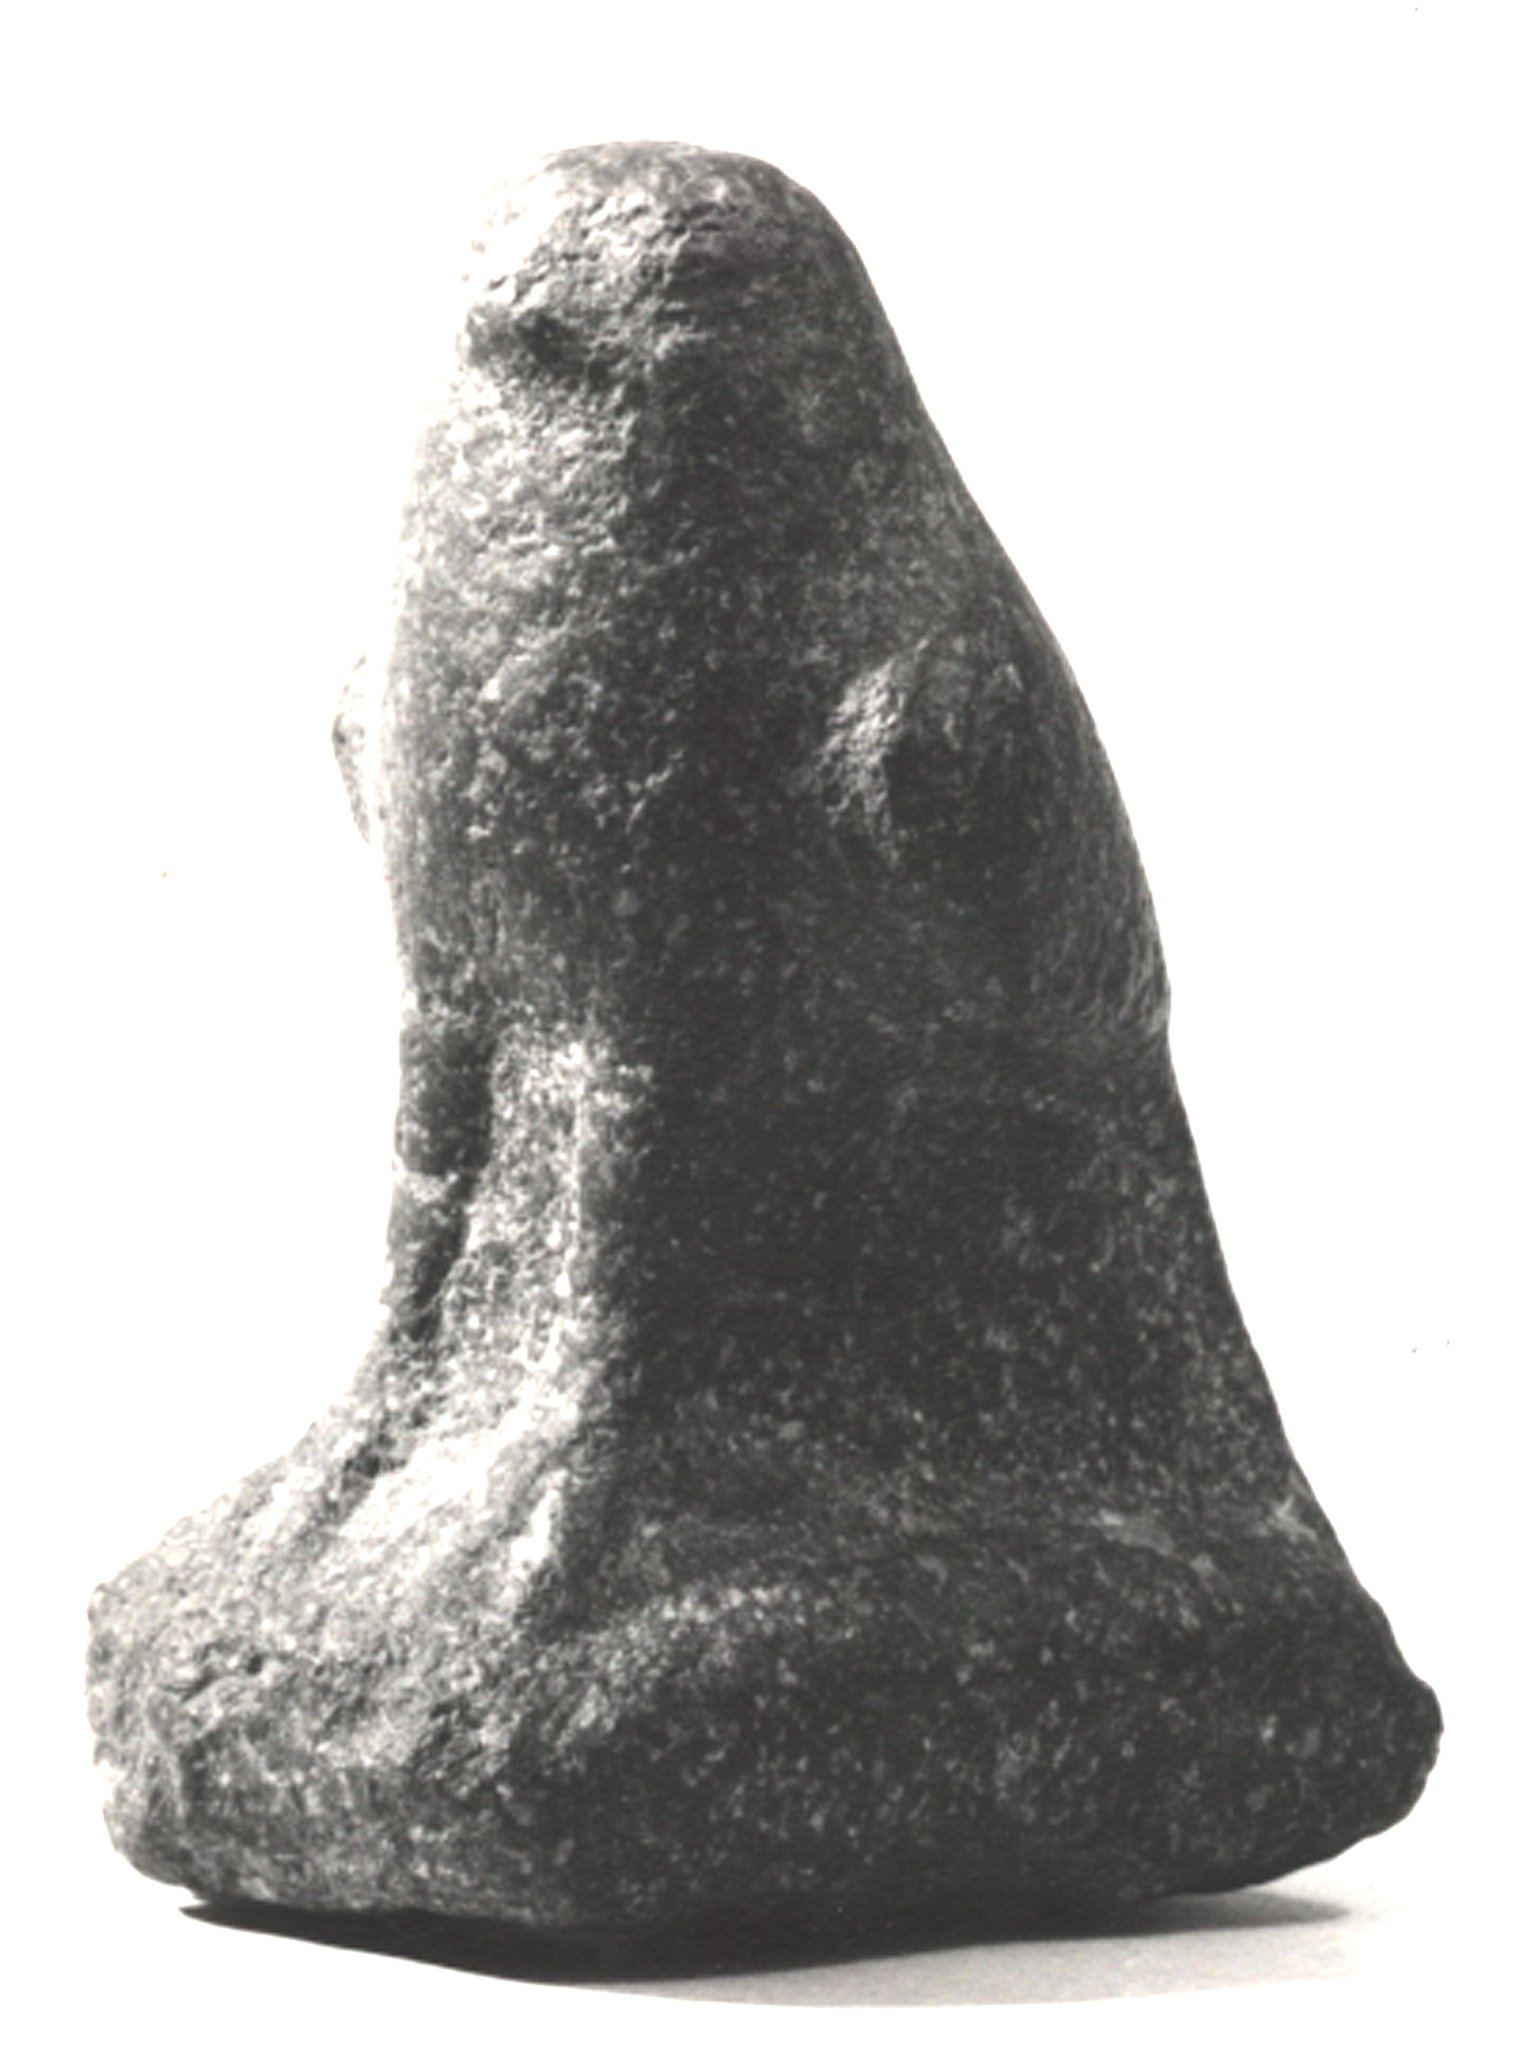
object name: statuette, falcon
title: Statuette of a Falcon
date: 304-30 BCE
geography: egypt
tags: falcons